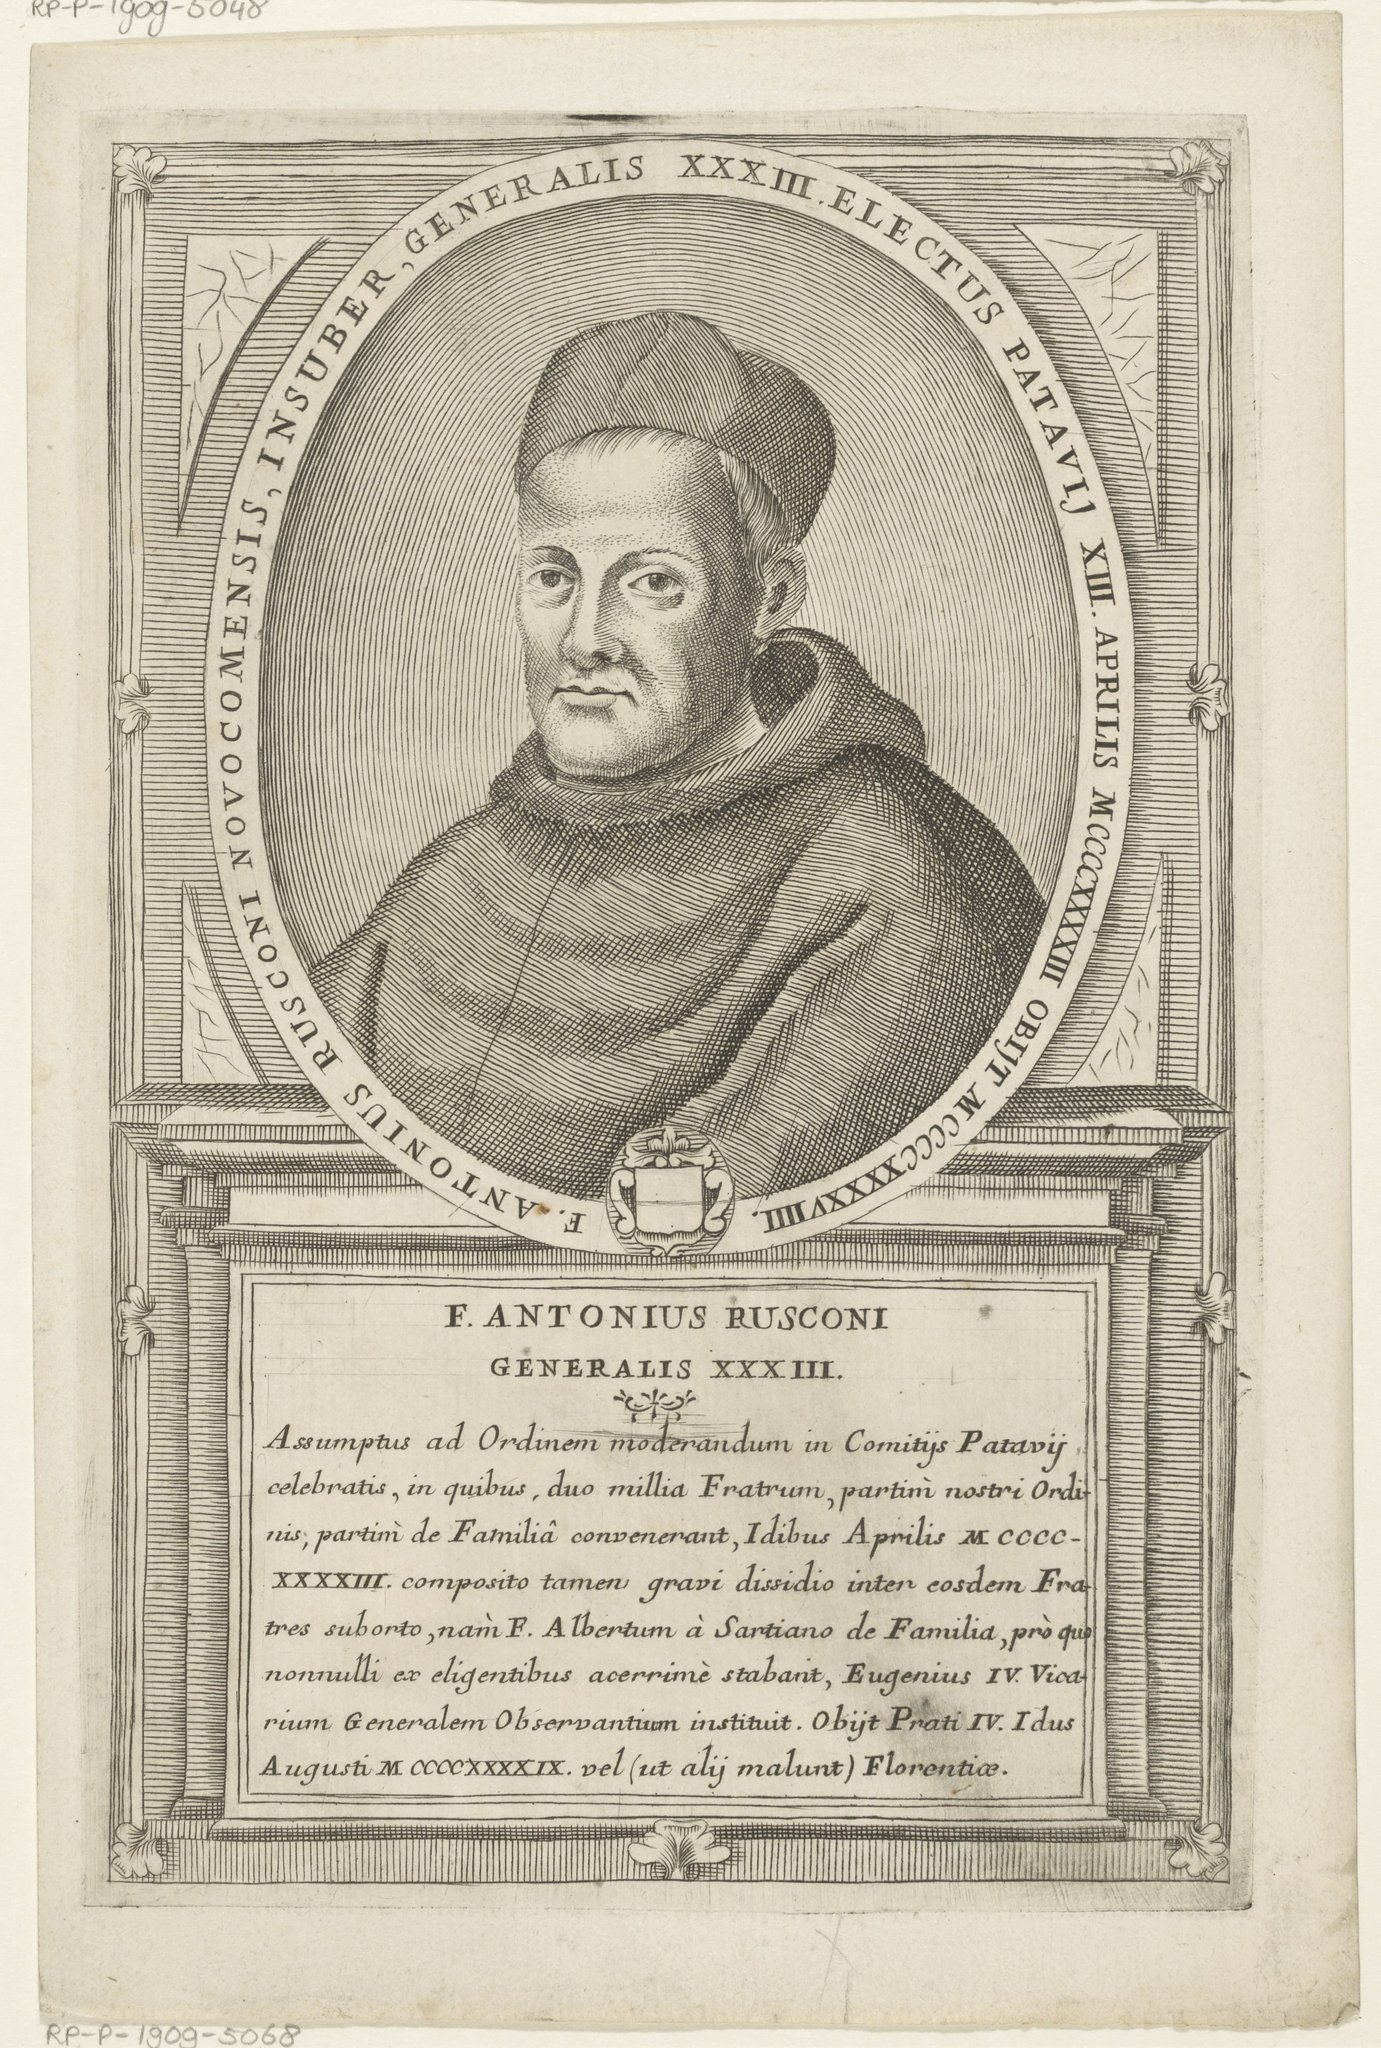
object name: print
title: Portretten van Ministers Generaal van de franciscaner orde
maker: antonio luciani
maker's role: print maker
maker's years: 1700-1738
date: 1710-1738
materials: paper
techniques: engraving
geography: italy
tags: historical persons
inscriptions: collector's mark: Lugt 2228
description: Deze prent maakt deel uit van een groep van 60 portretten.